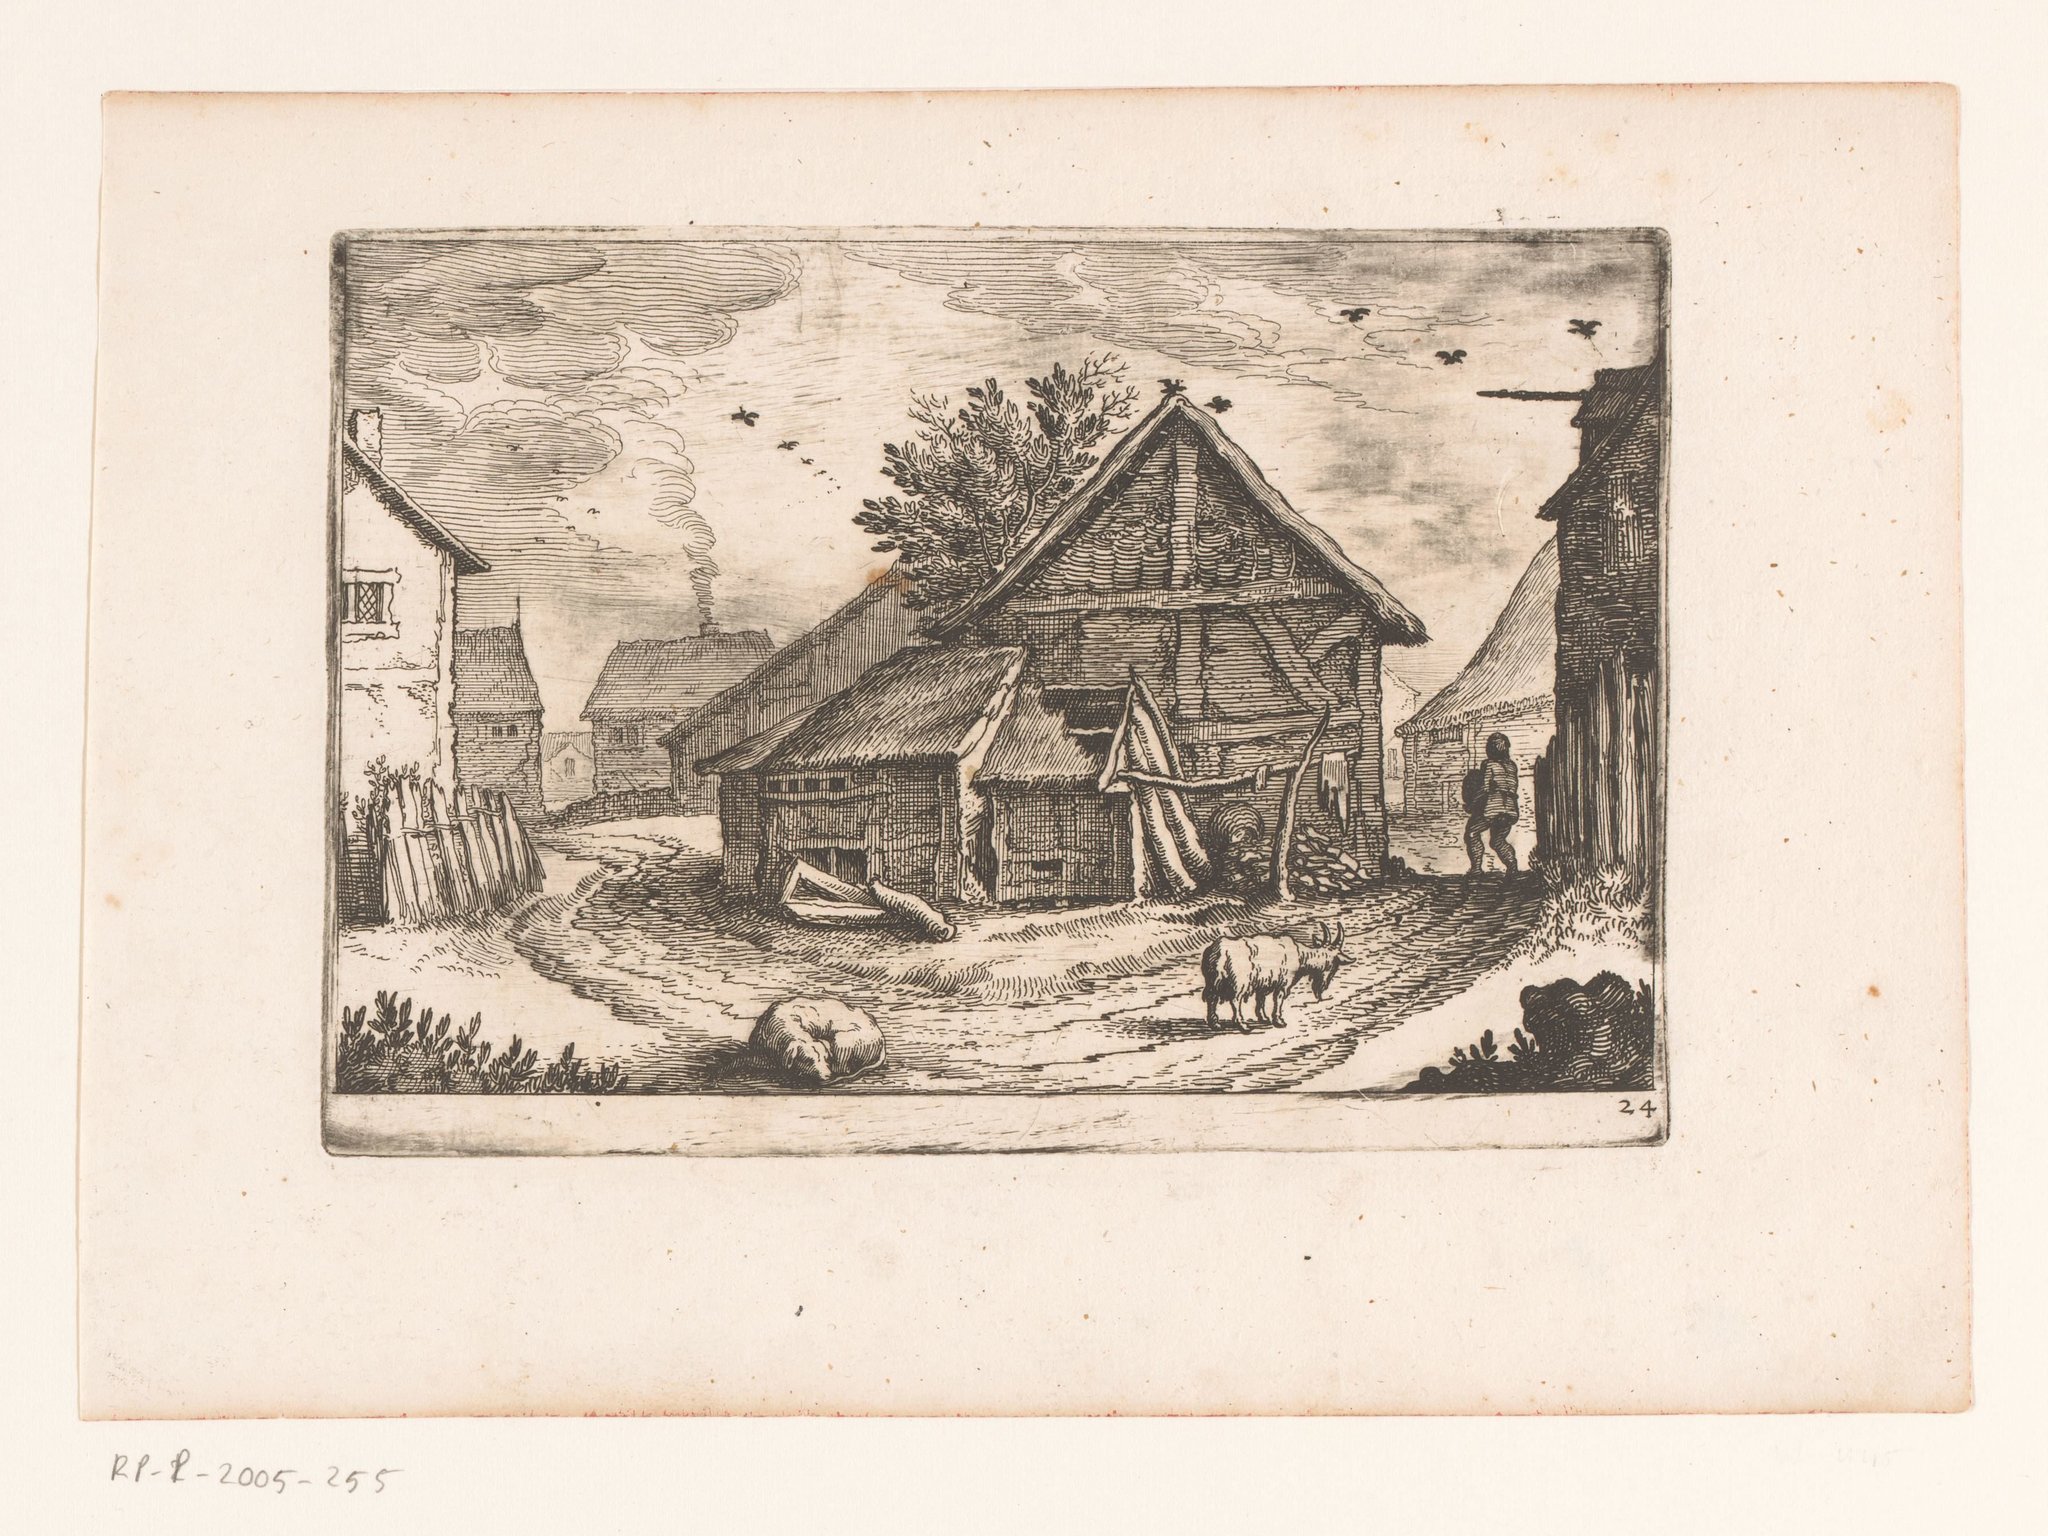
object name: print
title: Boerderij met schuren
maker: matthäus merian (i)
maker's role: print maker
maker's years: 1593-1650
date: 1620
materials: paper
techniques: etching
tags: adult man, village street, goat, farm (building), dog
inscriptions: collector's mark: Lugt 2760, collector's mark: Lugt 2228